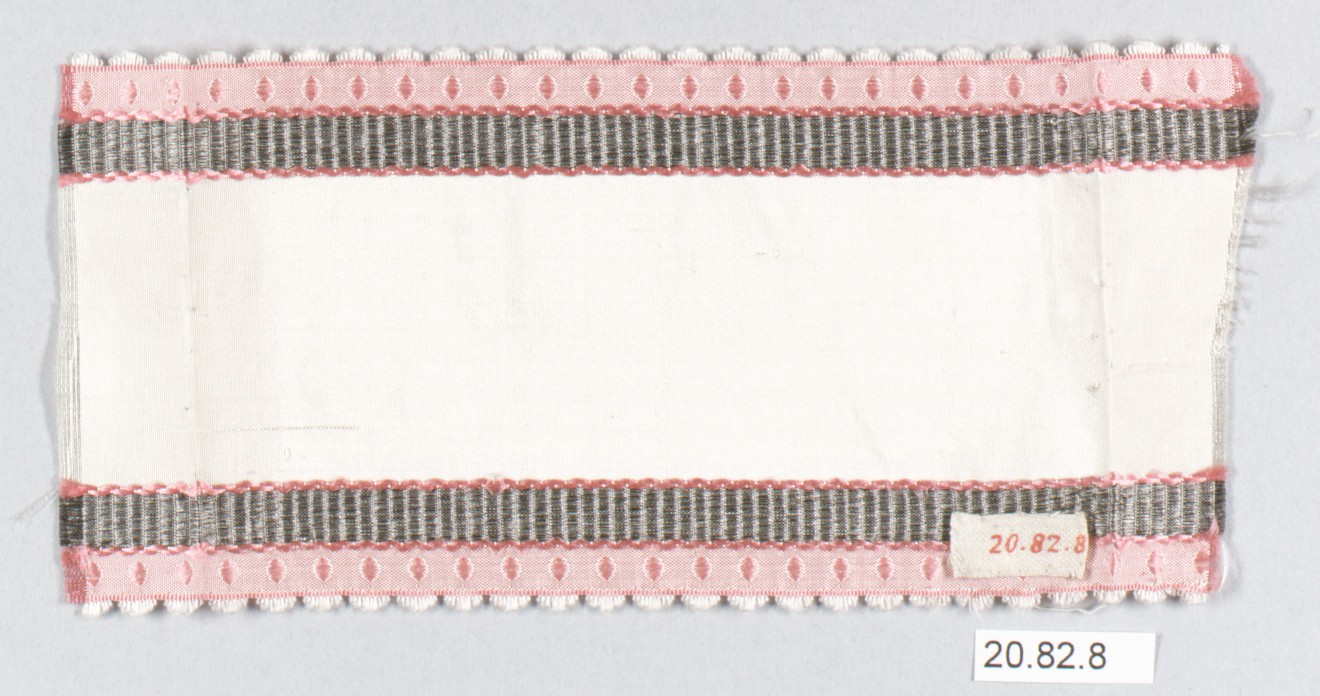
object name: ribbon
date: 1801-1833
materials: silk